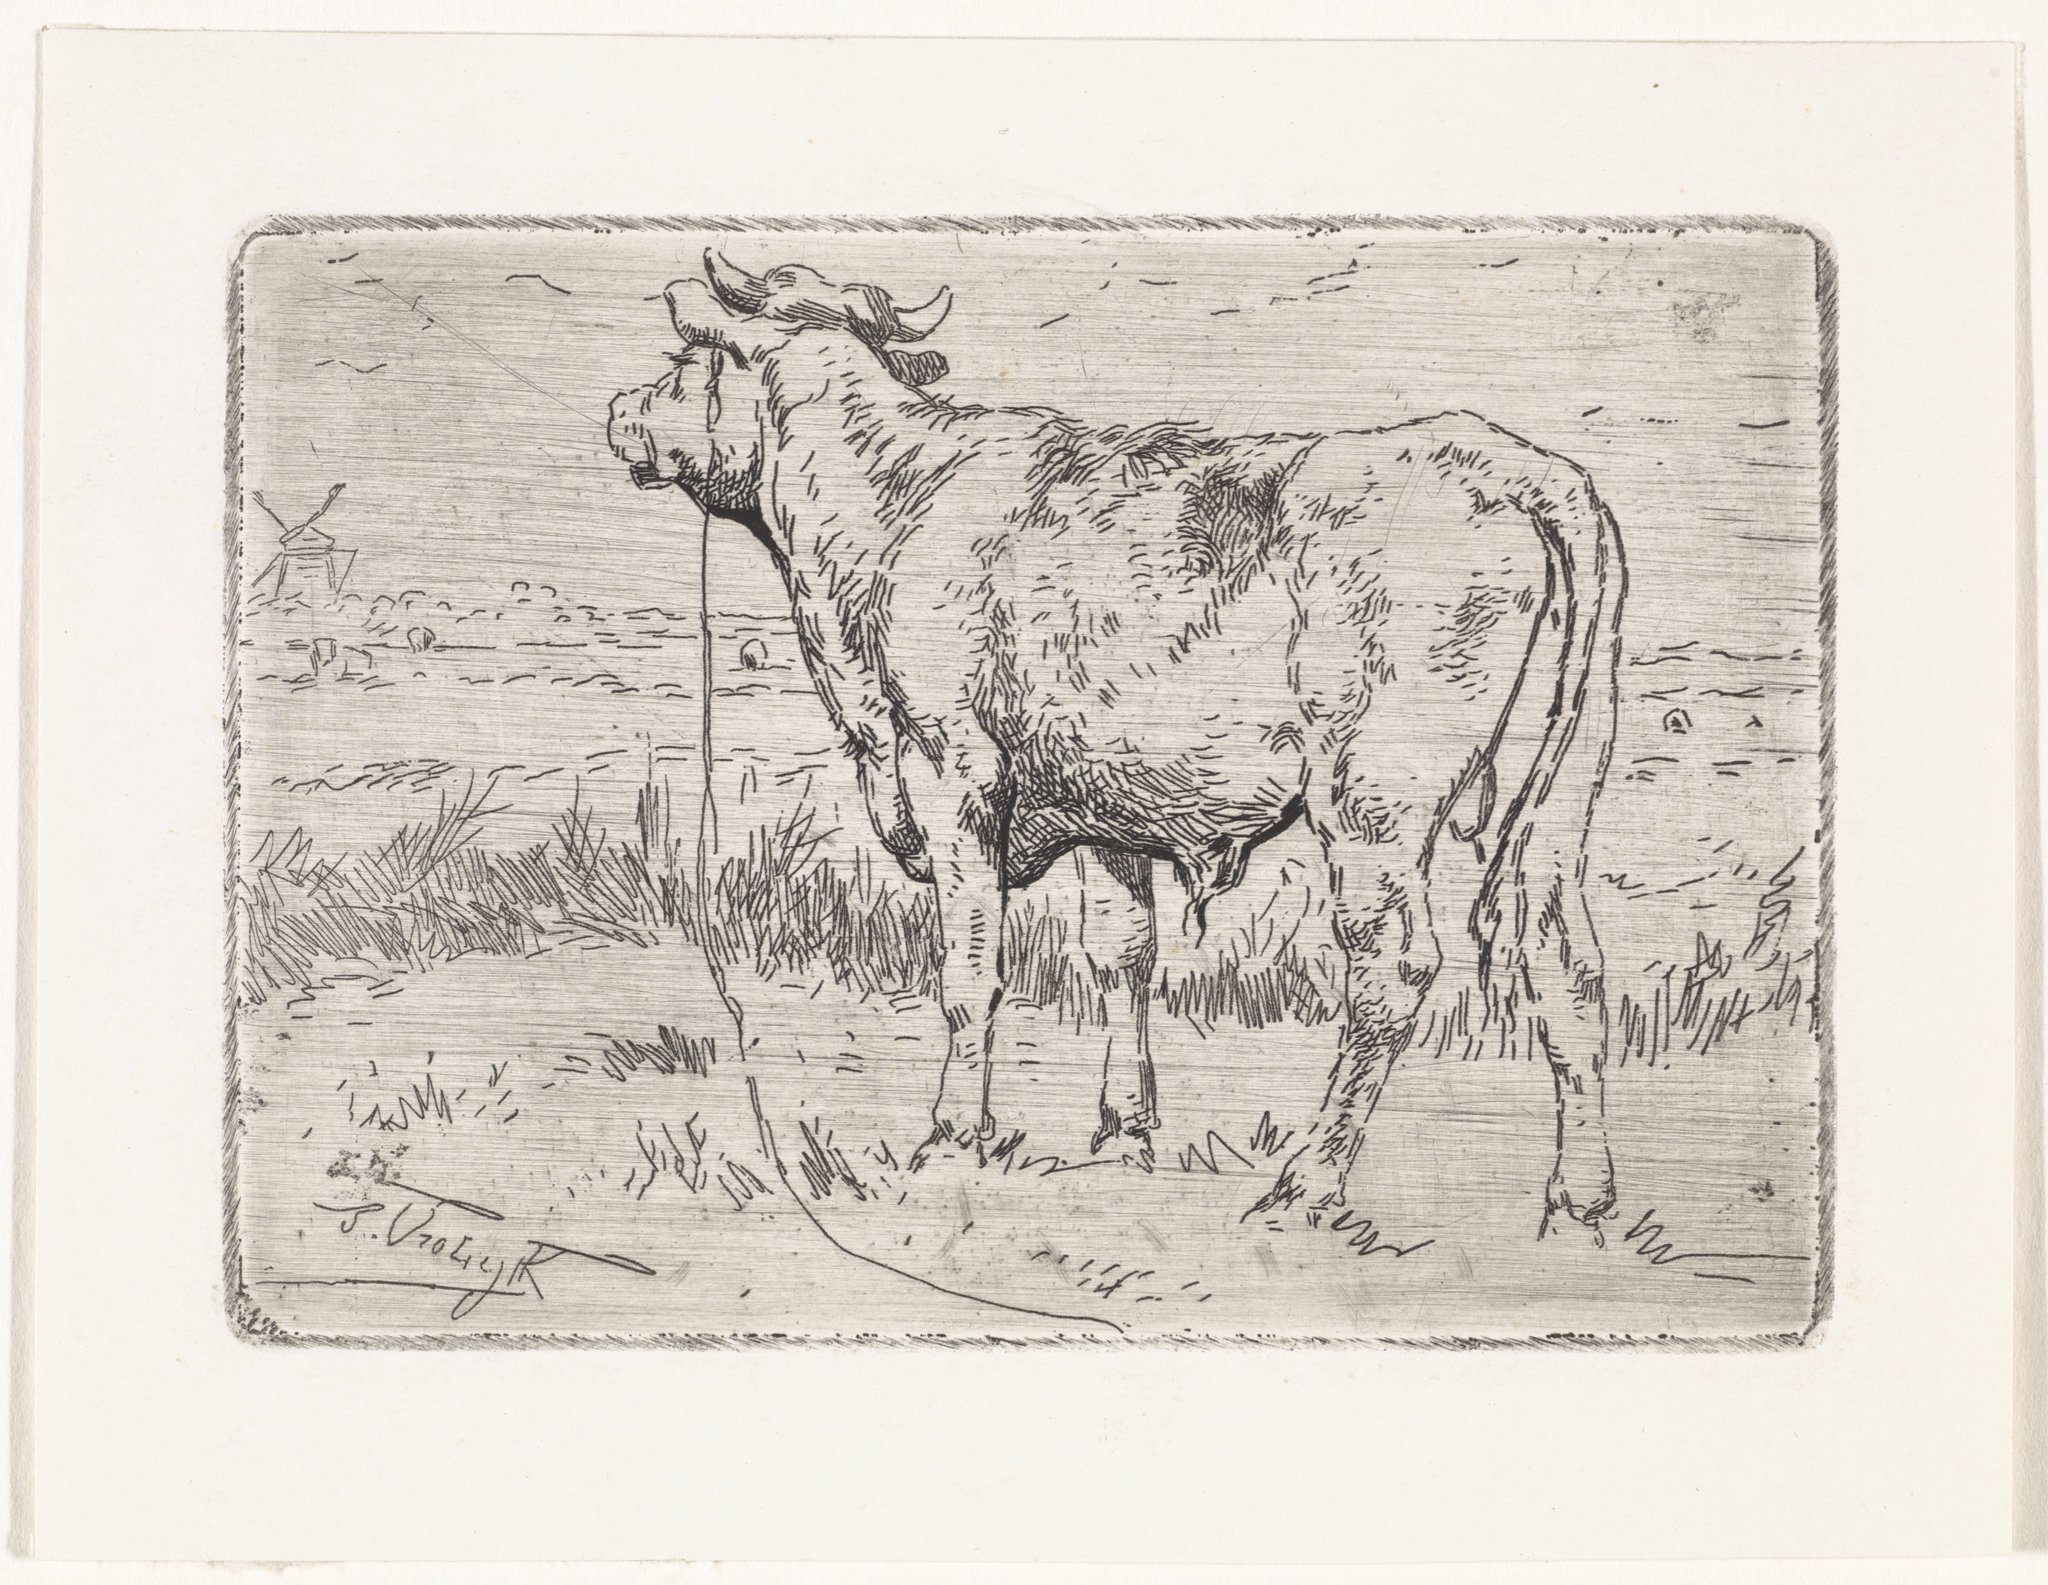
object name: print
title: Landschap met stier, aan een touw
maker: jan vrolijk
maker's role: draughtsman, painter, print maker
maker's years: 1846-1894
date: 1860-1892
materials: paper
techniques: etching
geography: the hague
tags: bull, windmill in landscape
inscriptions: collector's mark: Lugt 2228